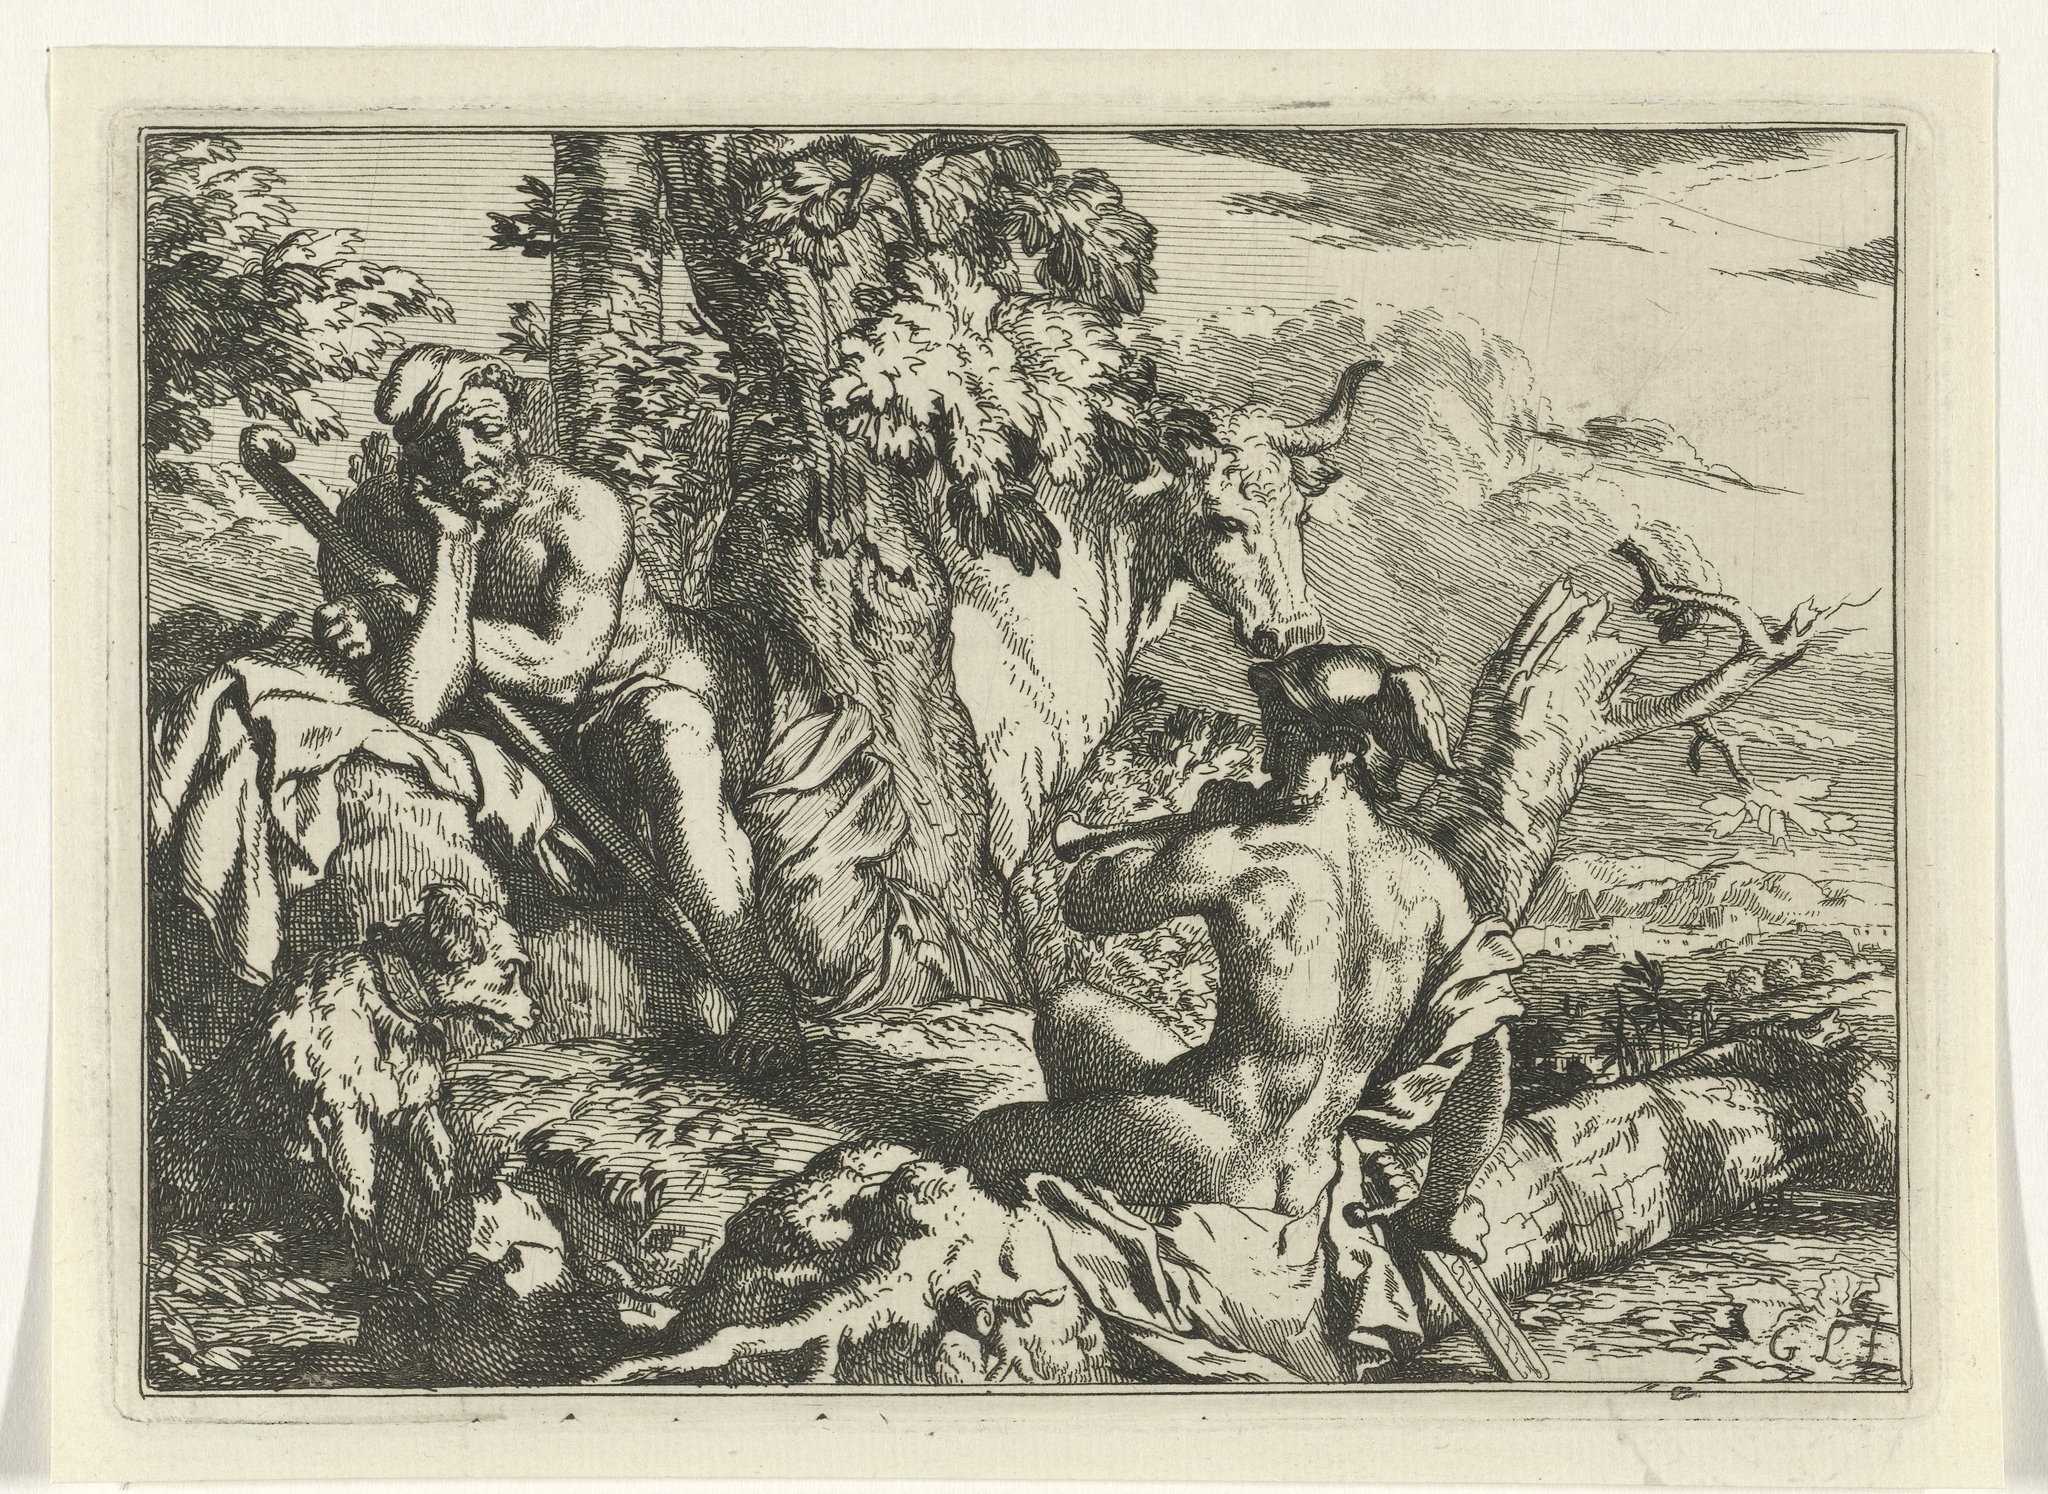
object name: print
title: Geschiedenis van Argus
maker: gerard de lairesse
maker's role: draughtsman, painter, print maker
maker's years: 1641-1711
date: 1670-1672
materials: paper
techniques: etching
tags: mercury lulls argus into sleep by making music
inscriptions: collector's mark: Lugt 240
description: Argus valt naast een boom in slaap bij de muziek die Mercurius met zijn herdersfluit maakt. Al fluitspelend grijpt Mercurius naar zijn zwaard om Argus te doden. Op deze manier zou Io, de in een witte koe veranderde geliefde van Jupiter, bevrijd kunnen worden. Achter de boom kijkt de witte koe (Io) toe, links zit een hond. De prent maakt deel uit van een vierdelige serie prenten met scènes uit het mythologische verhaal van Argus.